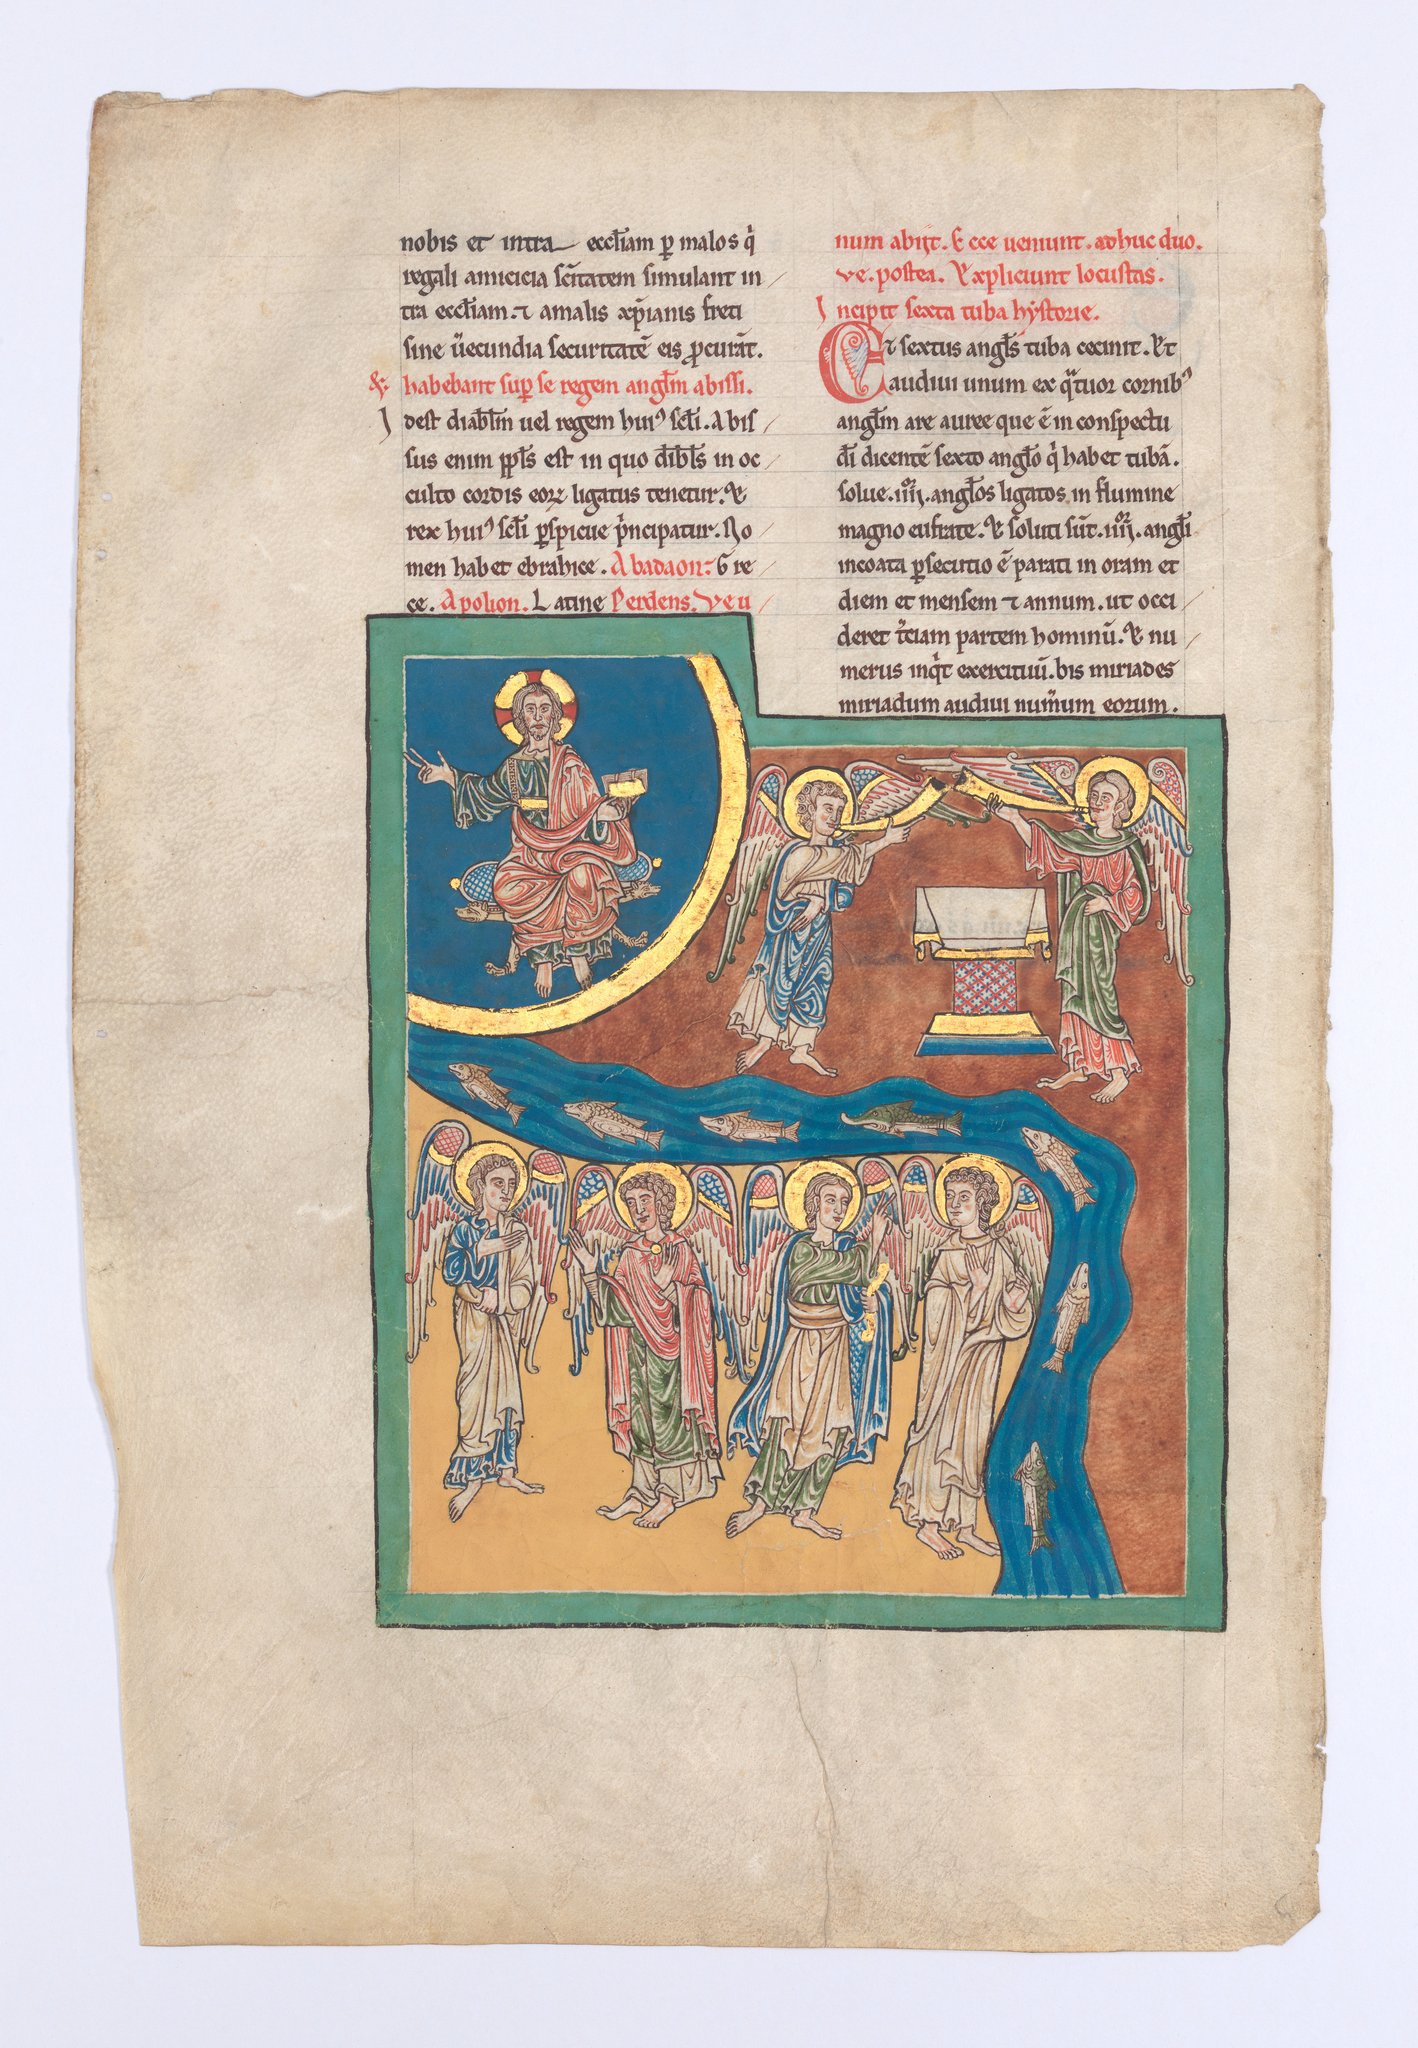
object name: beatus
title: Leaf from a Beatus Manuscript: the Sixth Angel Delivers the Four Angels that had been Bound at the River Euphrates; an Altar Appears in the Heavens as the Enthroned Christ Raises His Hand in Blessing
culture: spanish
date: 1180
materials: gold, ink, parchment, paint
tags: fish,angels,christ